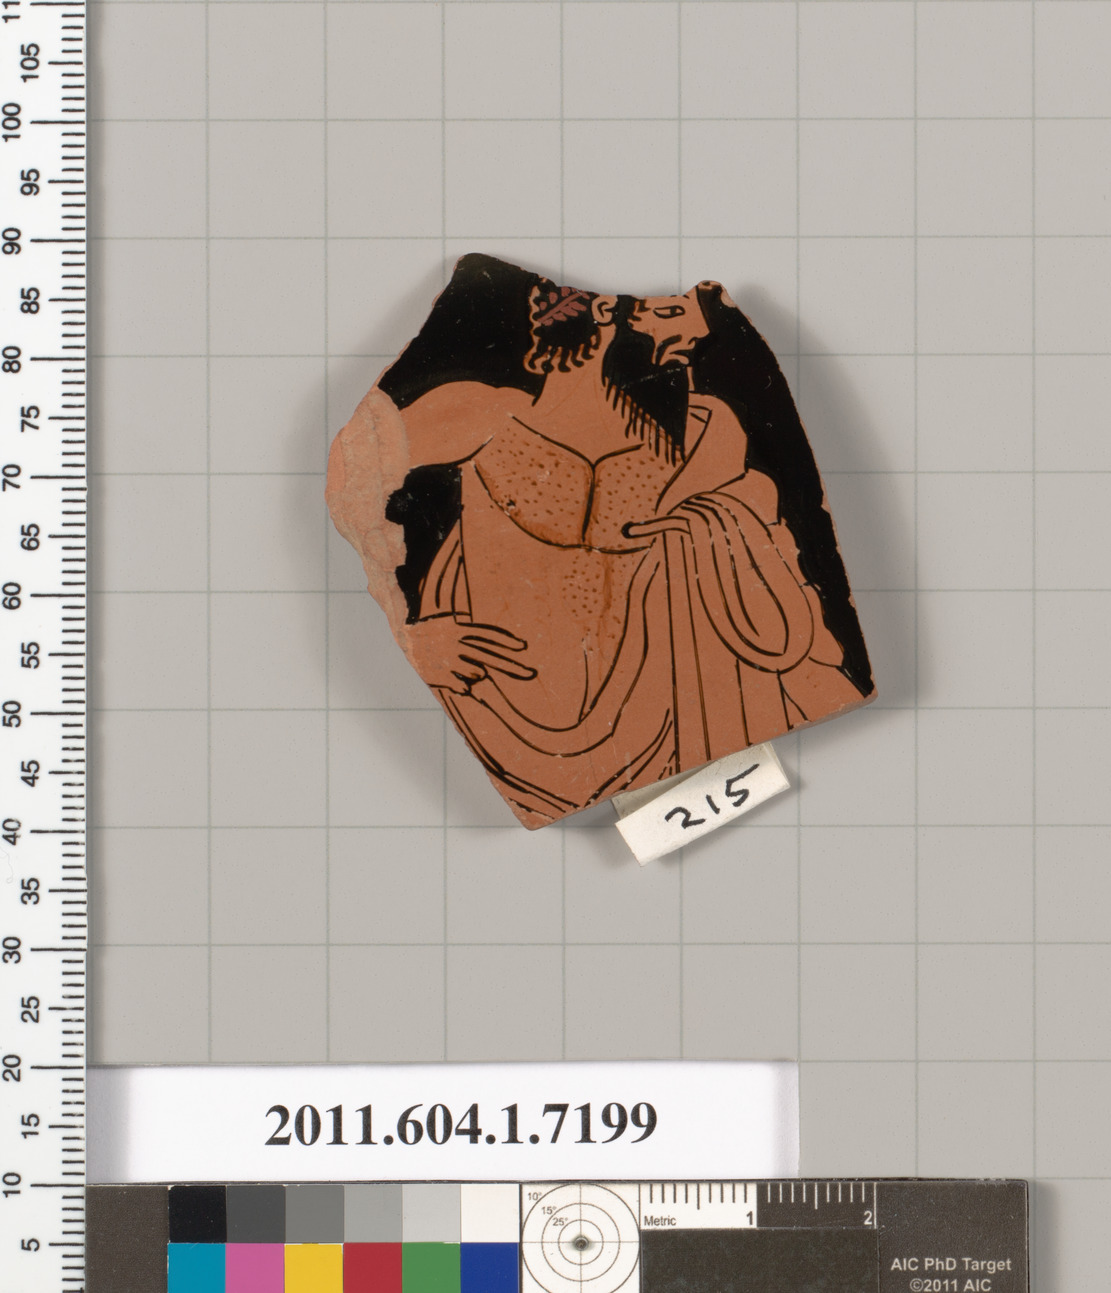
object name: kylix fragment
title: Terracotta fragment of a kylix (drinking cup)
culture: greek, attic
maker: makron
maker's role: artist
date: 500-480 BCE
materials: terracotta